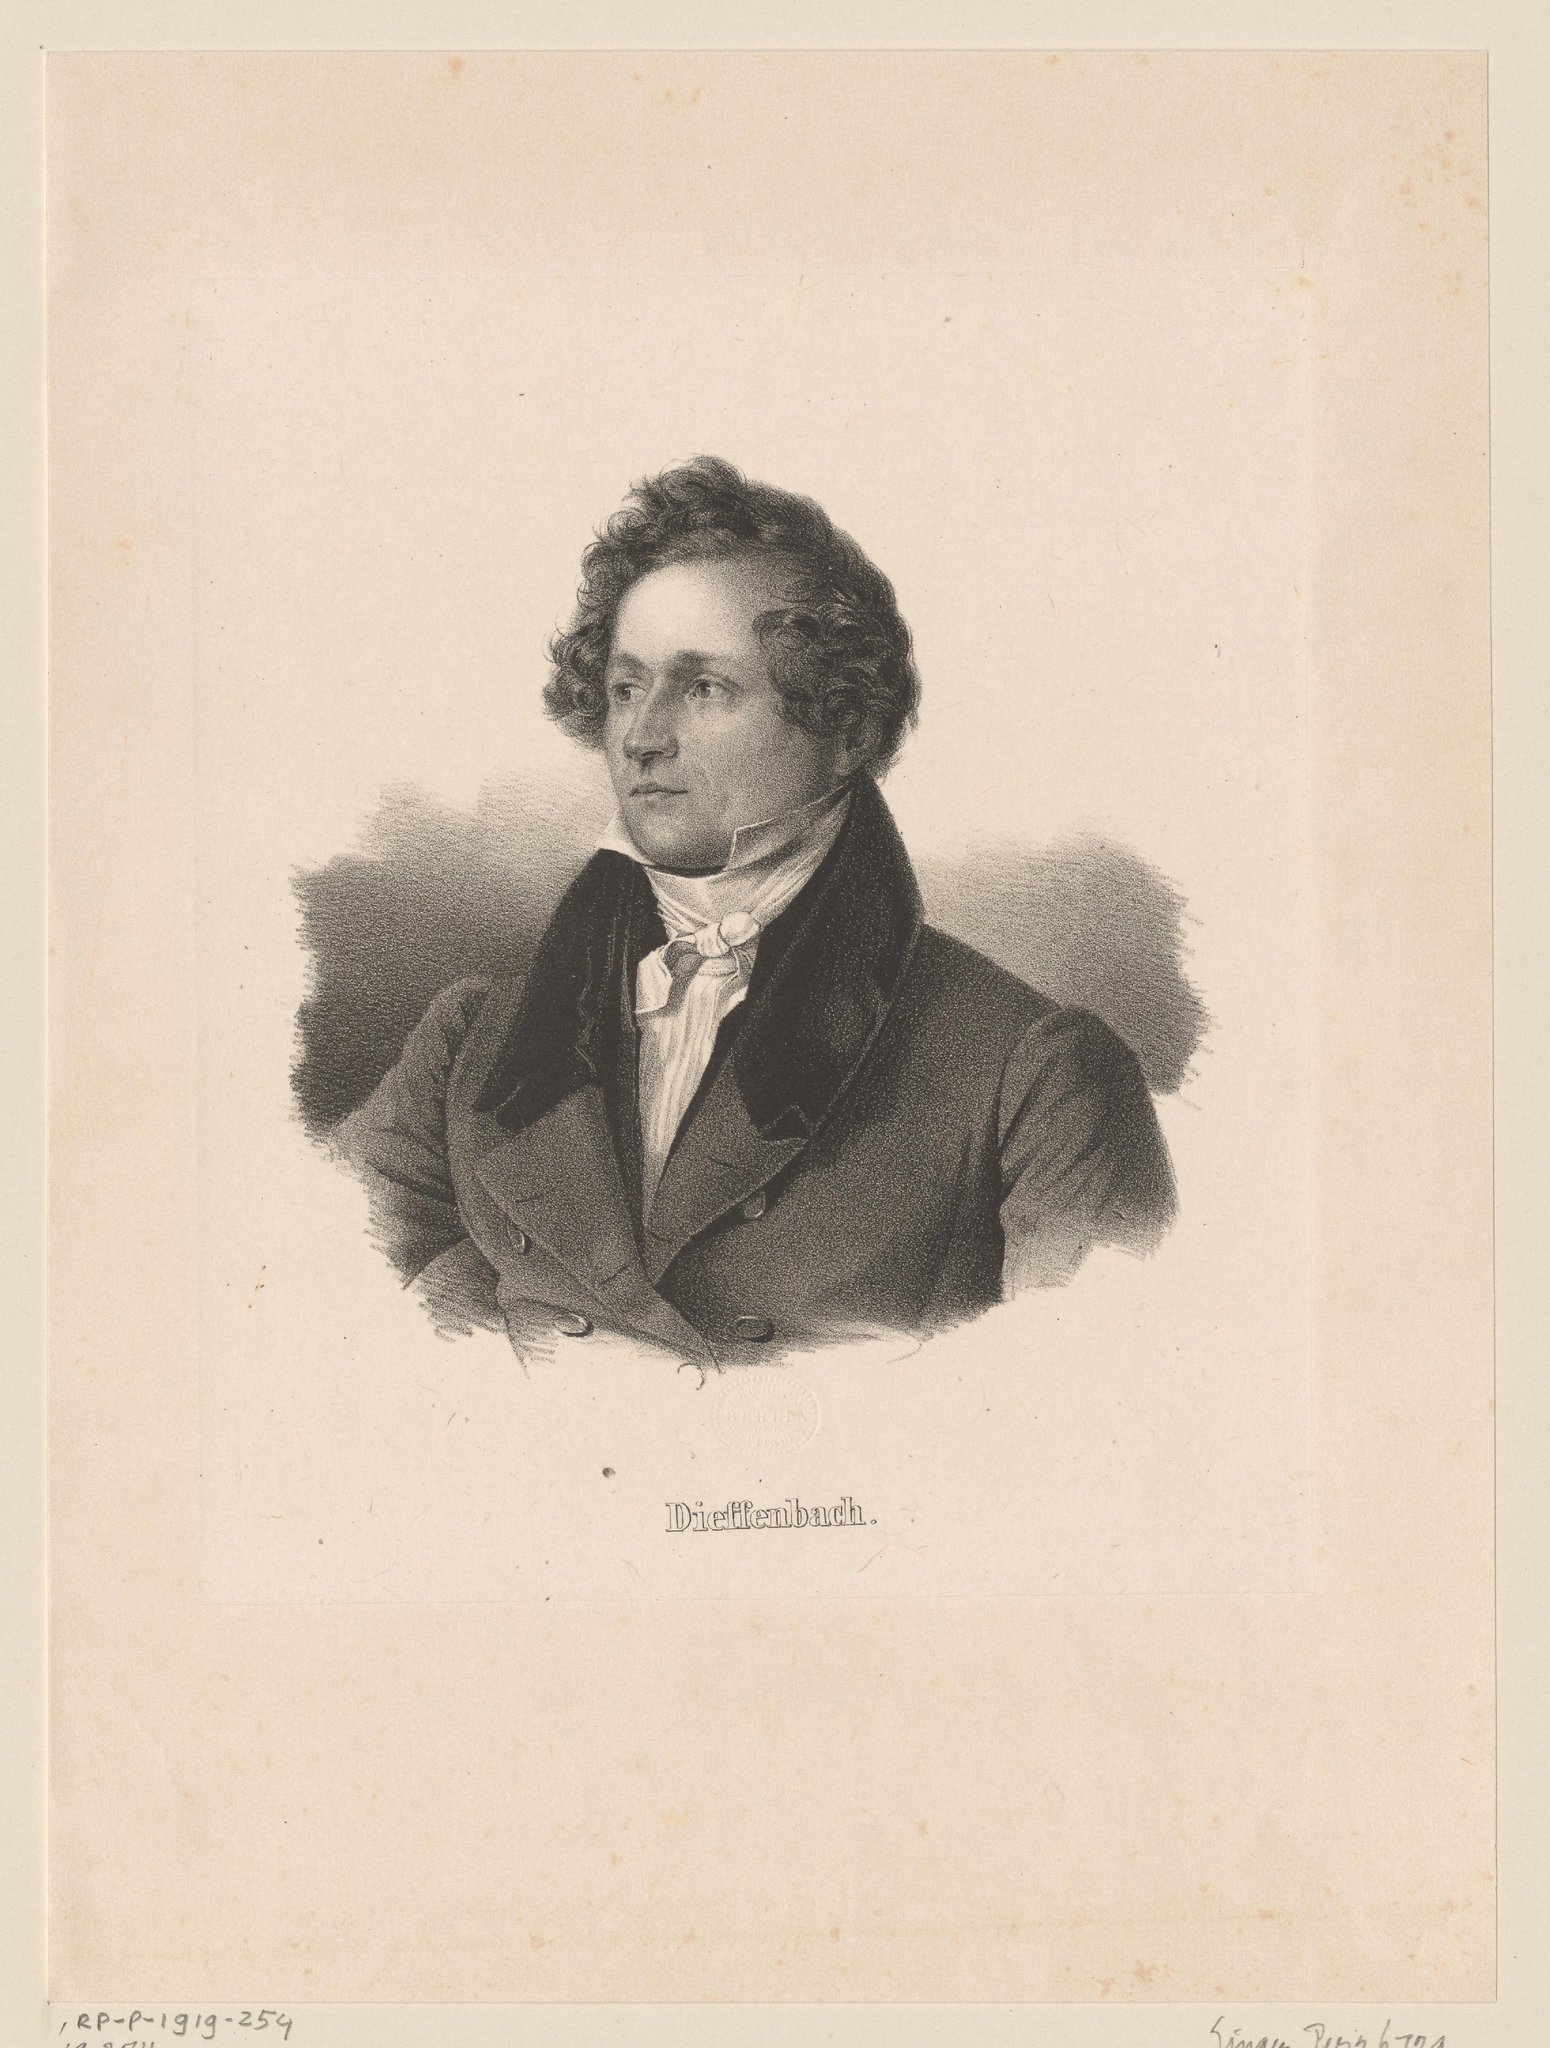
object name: print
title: Portret van Johann Friedrich Dieffenbach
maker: Anonymous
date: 1815-1874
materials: paper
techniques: lithograph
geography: berlin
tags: berlin, historical persons, barber; surgeon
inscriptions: check stamp: ‘Geb. Rocca in Berlin und Göttingen’, collector's mark: Lugt 2228